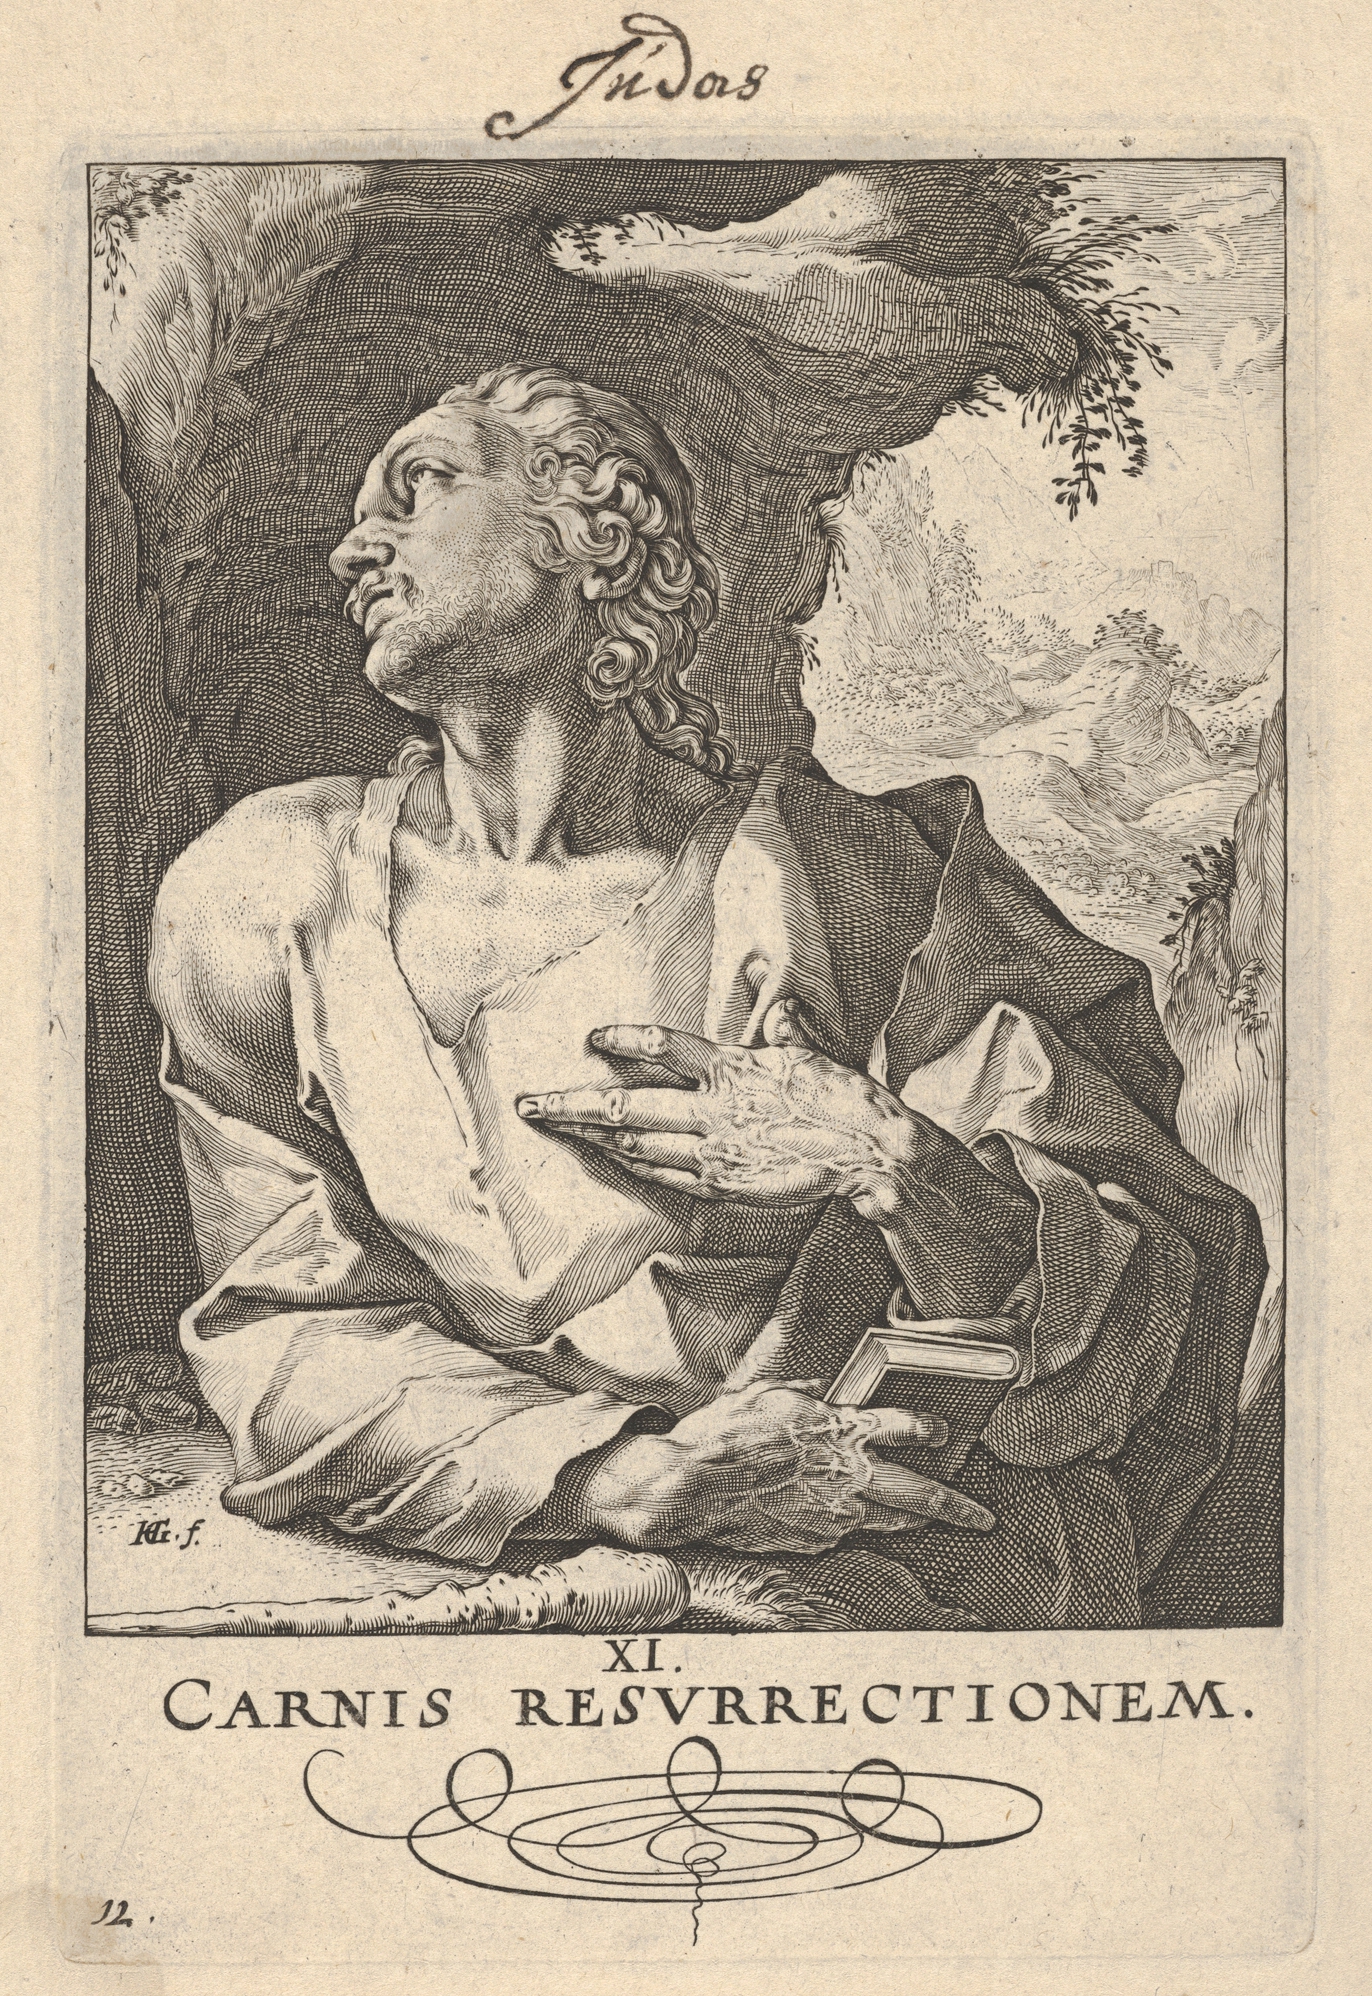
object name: print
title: St. Jude Thaddeus, from "Christ, the Apostles and St. Paul with the Creed"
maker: hendrick goltzius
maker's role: artist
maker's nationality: netherlandish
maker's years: 1558-1617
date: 1589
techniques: engraving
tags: men,saints